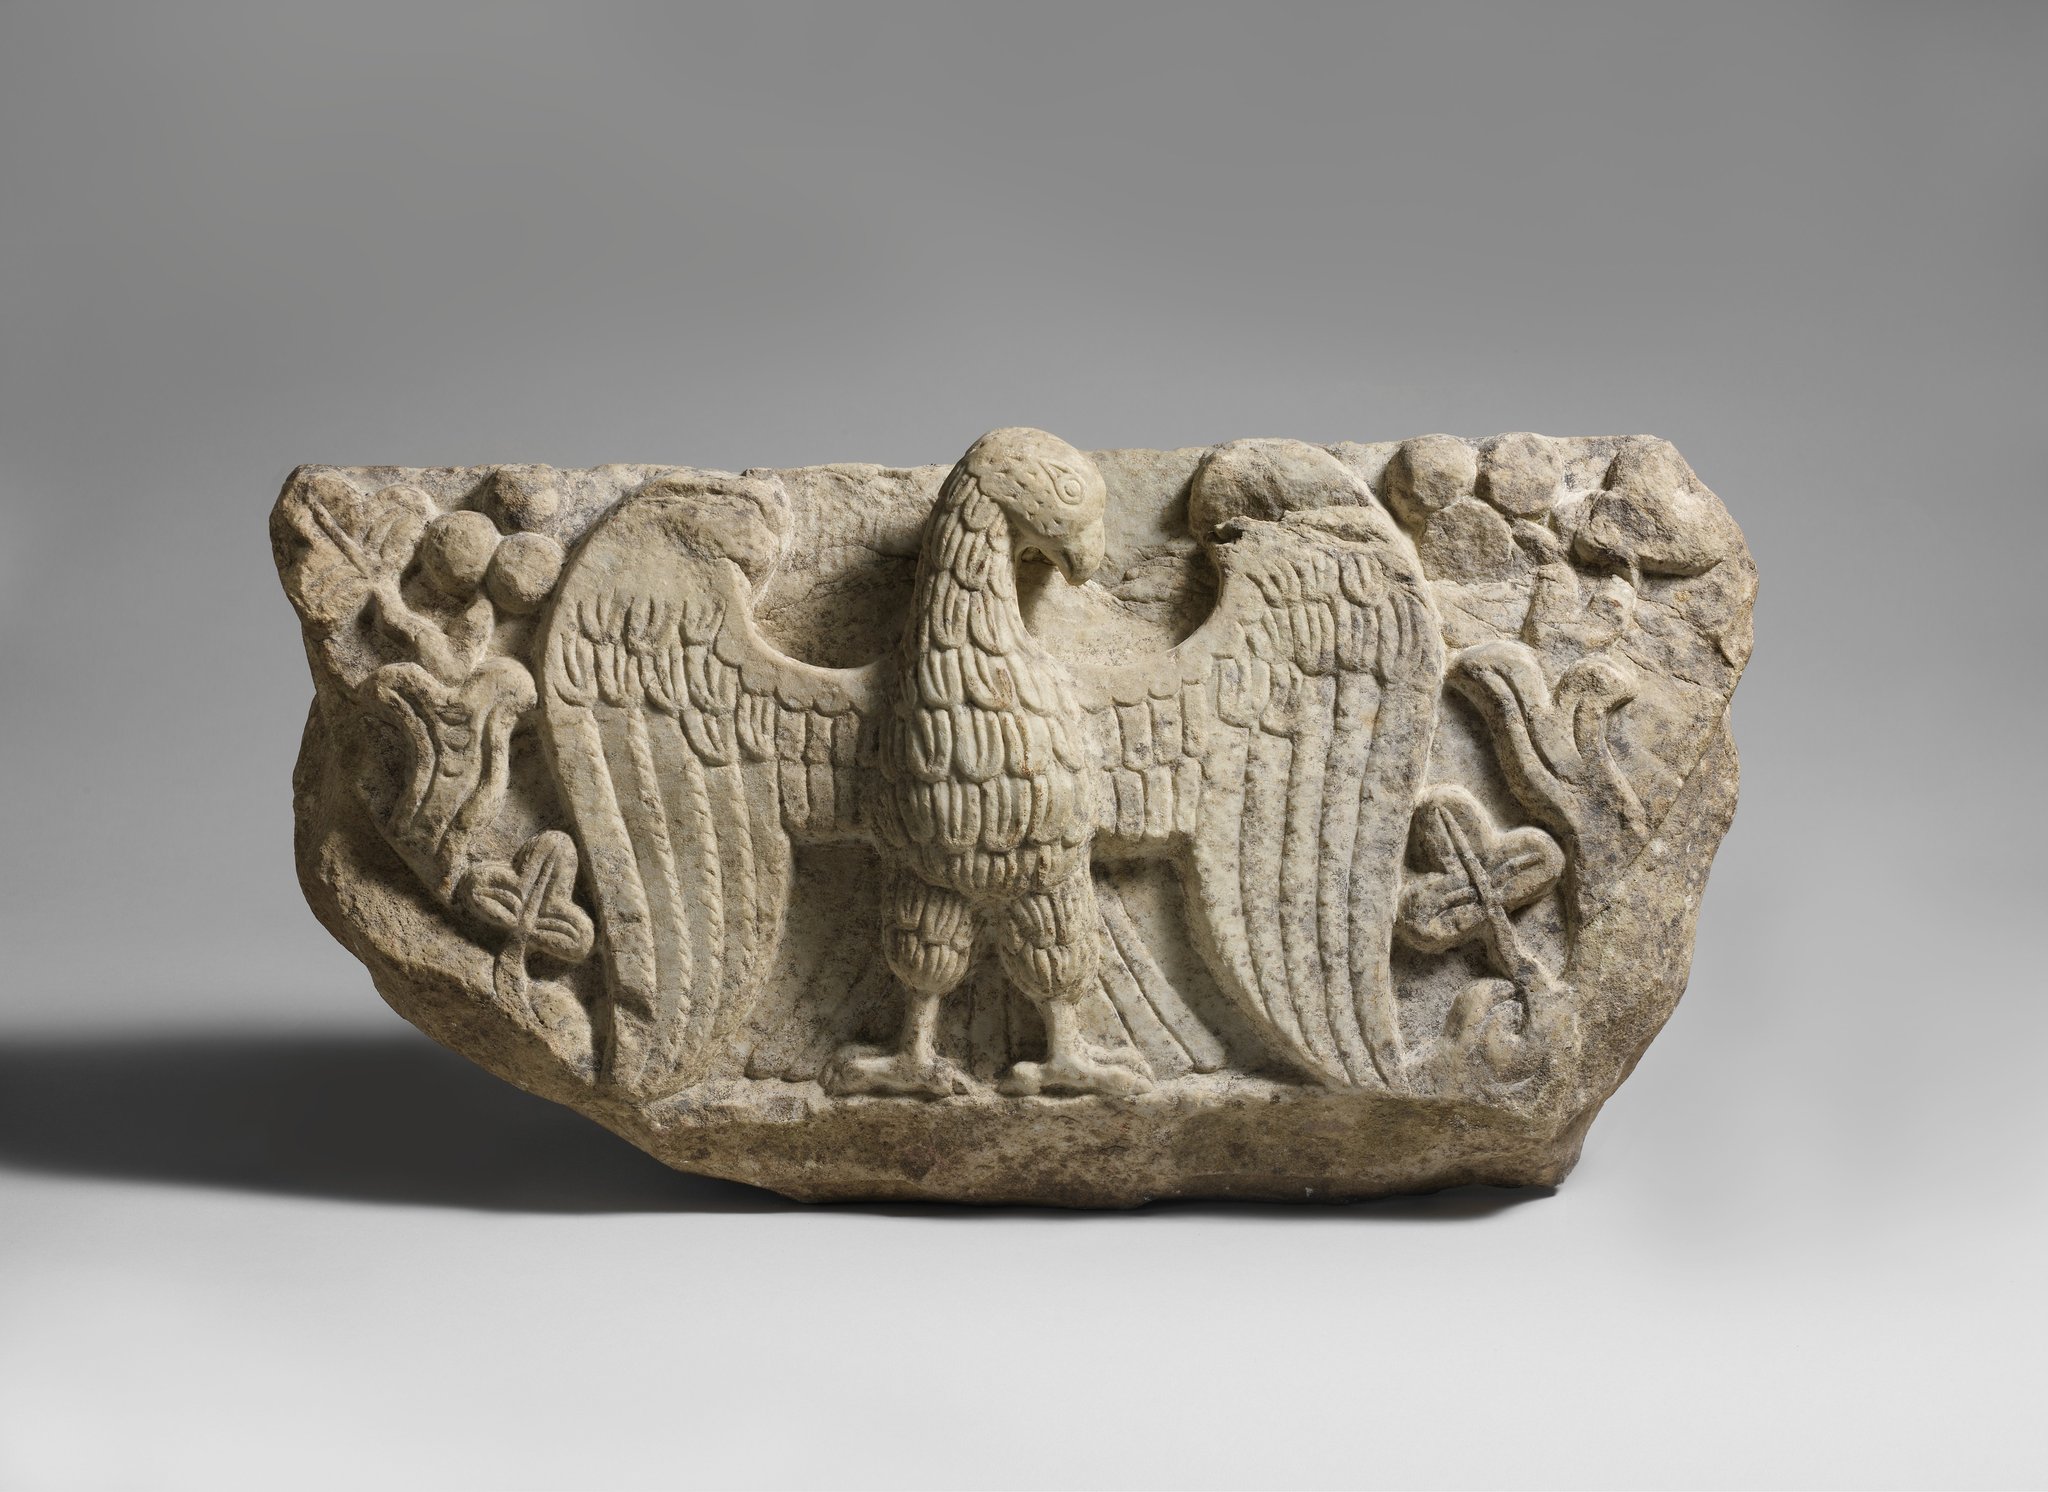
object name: relief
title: Eagle Relief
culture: italian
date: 1001-1100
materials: marble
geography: italy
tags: eagles